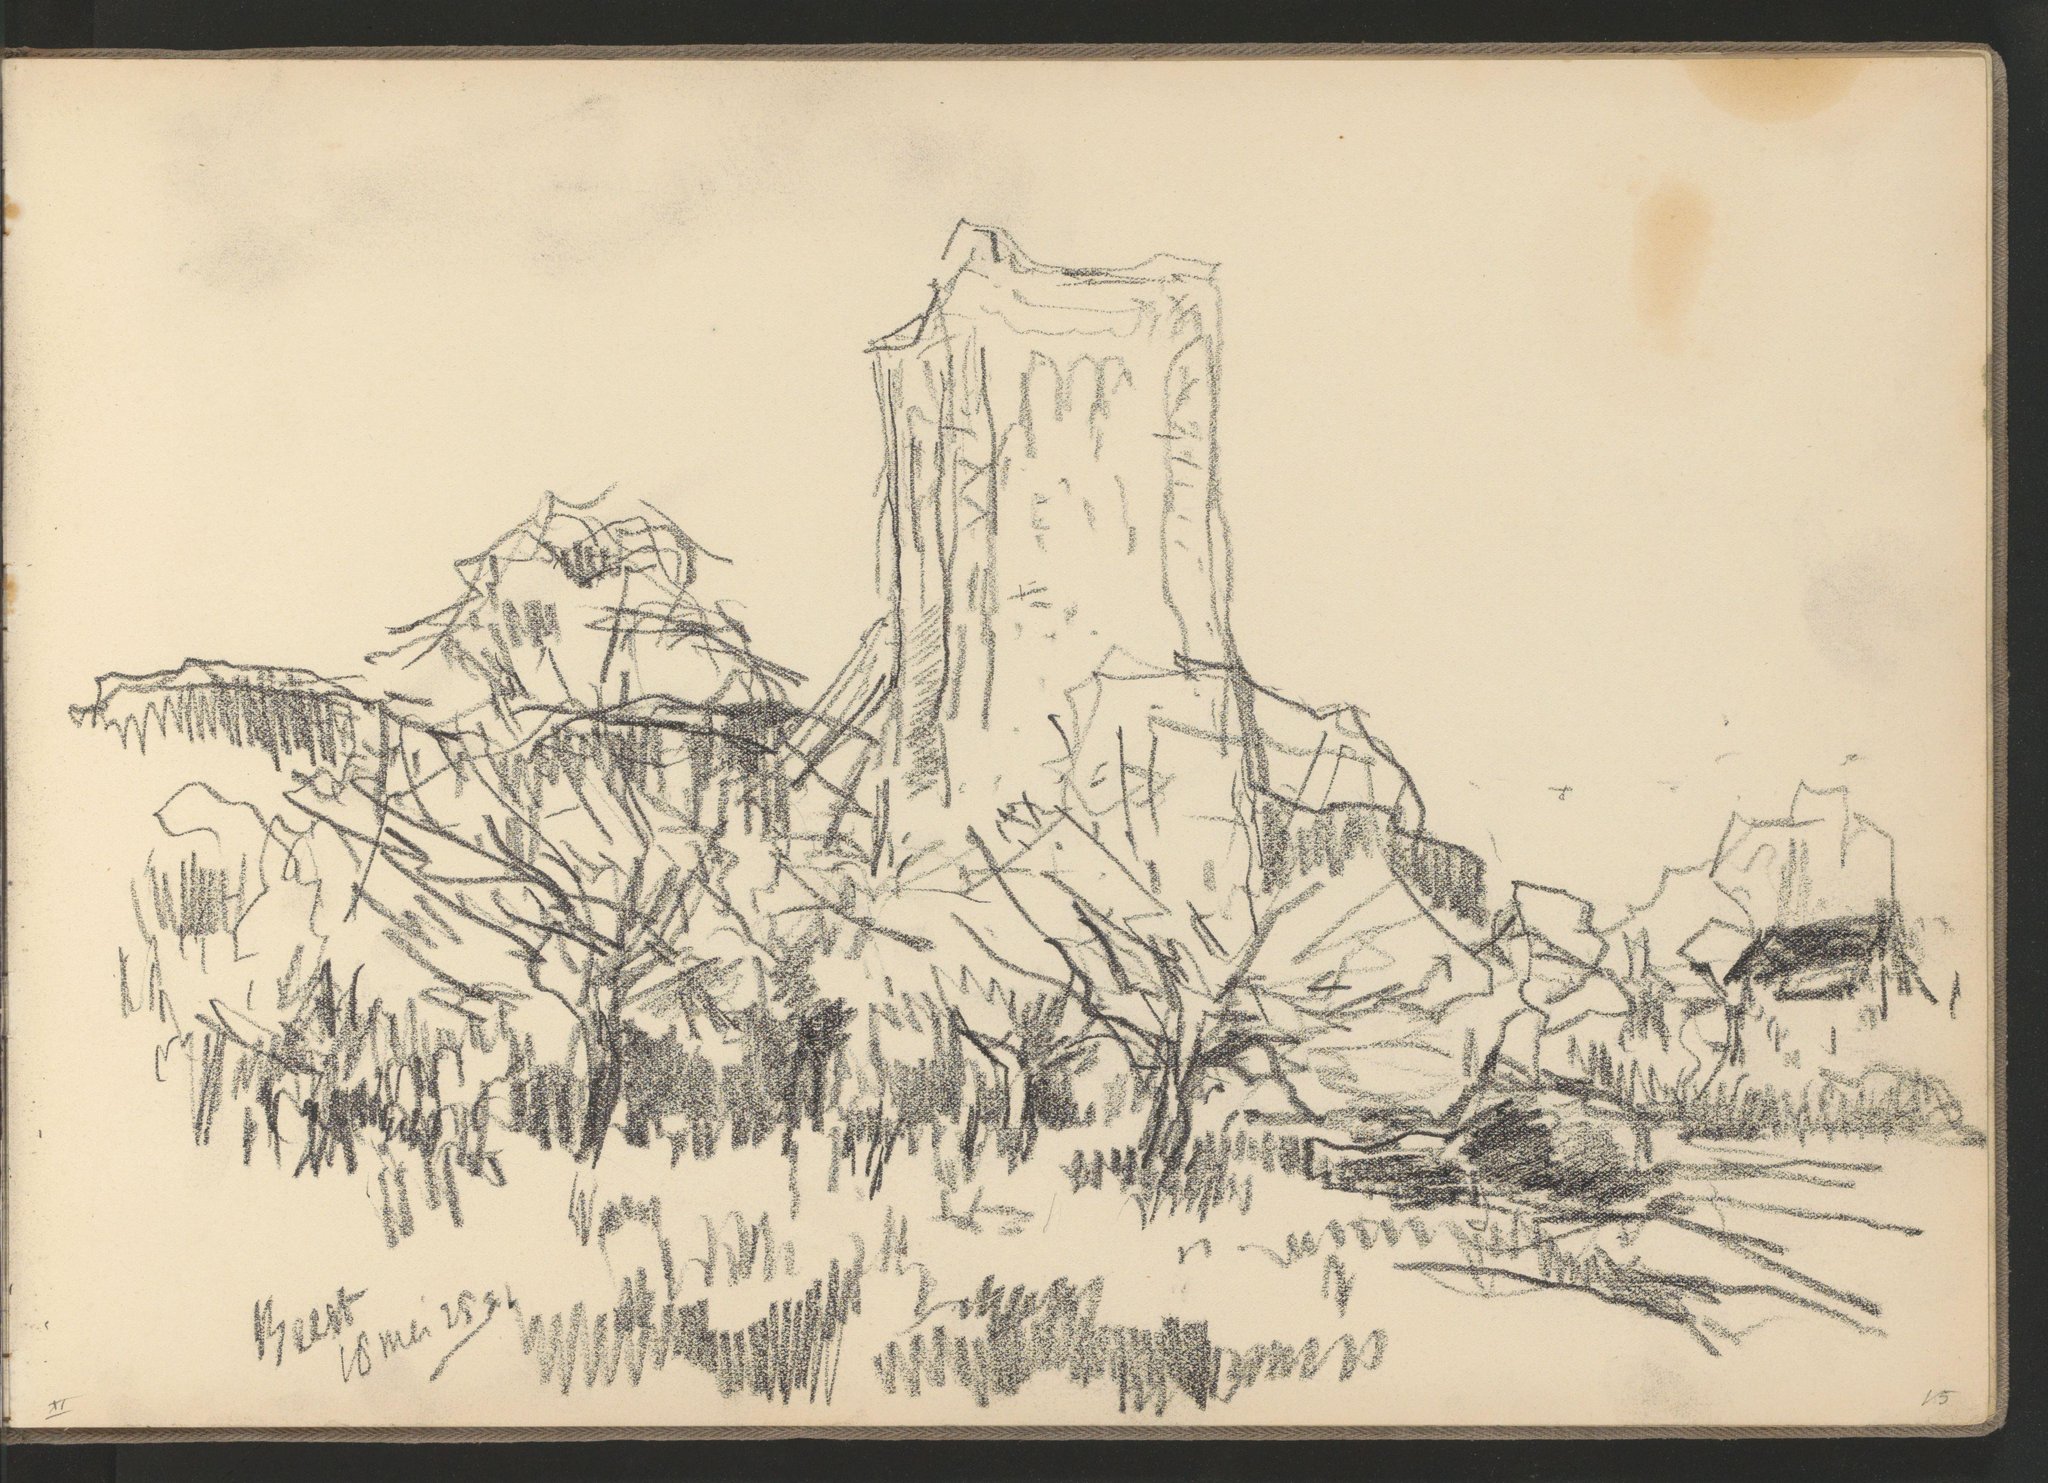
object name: sketchbook leaf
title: Sint-Pieterskerk te Beesd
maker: egbert rubertus derk schaap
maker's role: draughtsman, painter, print maker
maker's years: 1862-1939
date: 1805-1891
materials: paper, pencil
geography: beesd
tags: city-view, and landscape with man-made constructions, church (exterior)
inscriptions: date and inscription: ‘Beest/ 18 mei 1891’, number: ‘XI’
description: Pagina 15 uit een schetsboek met 64 pagina's.